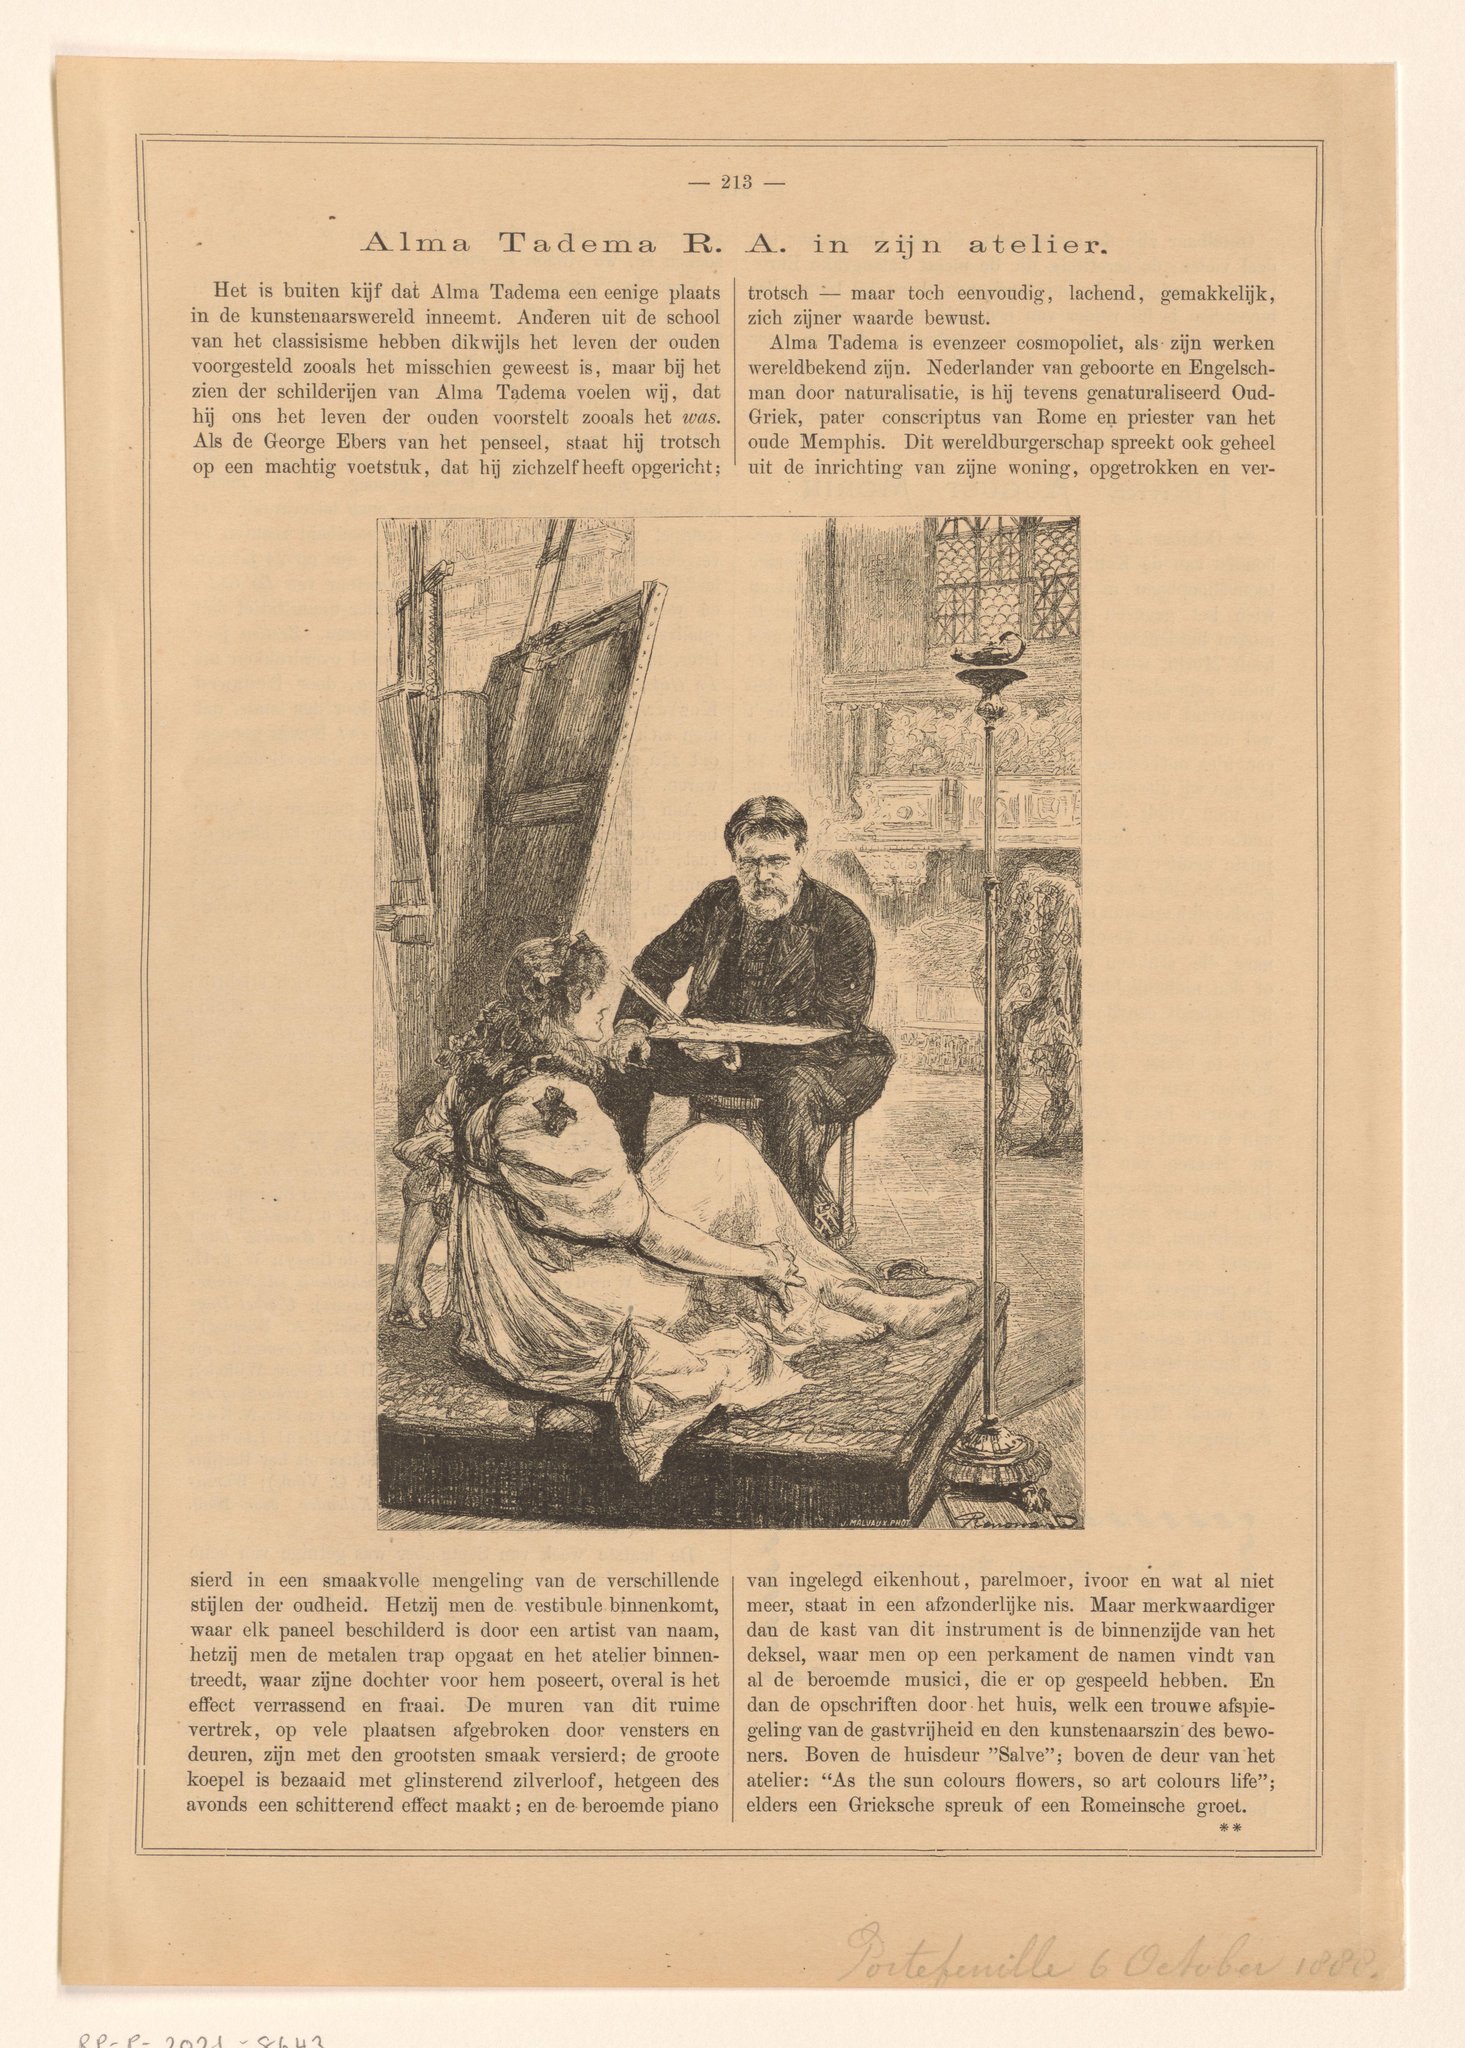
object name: photomechanical print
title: Schilder Lourens Alma Tadema in zijn atelier met een model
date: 1888-1890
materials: paper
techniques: letterpress printing, printing block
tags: print maker, draughtsman, lourens alma tadema, historical persons, portrait, self-portrait of painter, painter at work, in his studio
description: Prent mogelijk uit: De Portefeuille, 6 oktober 1888.